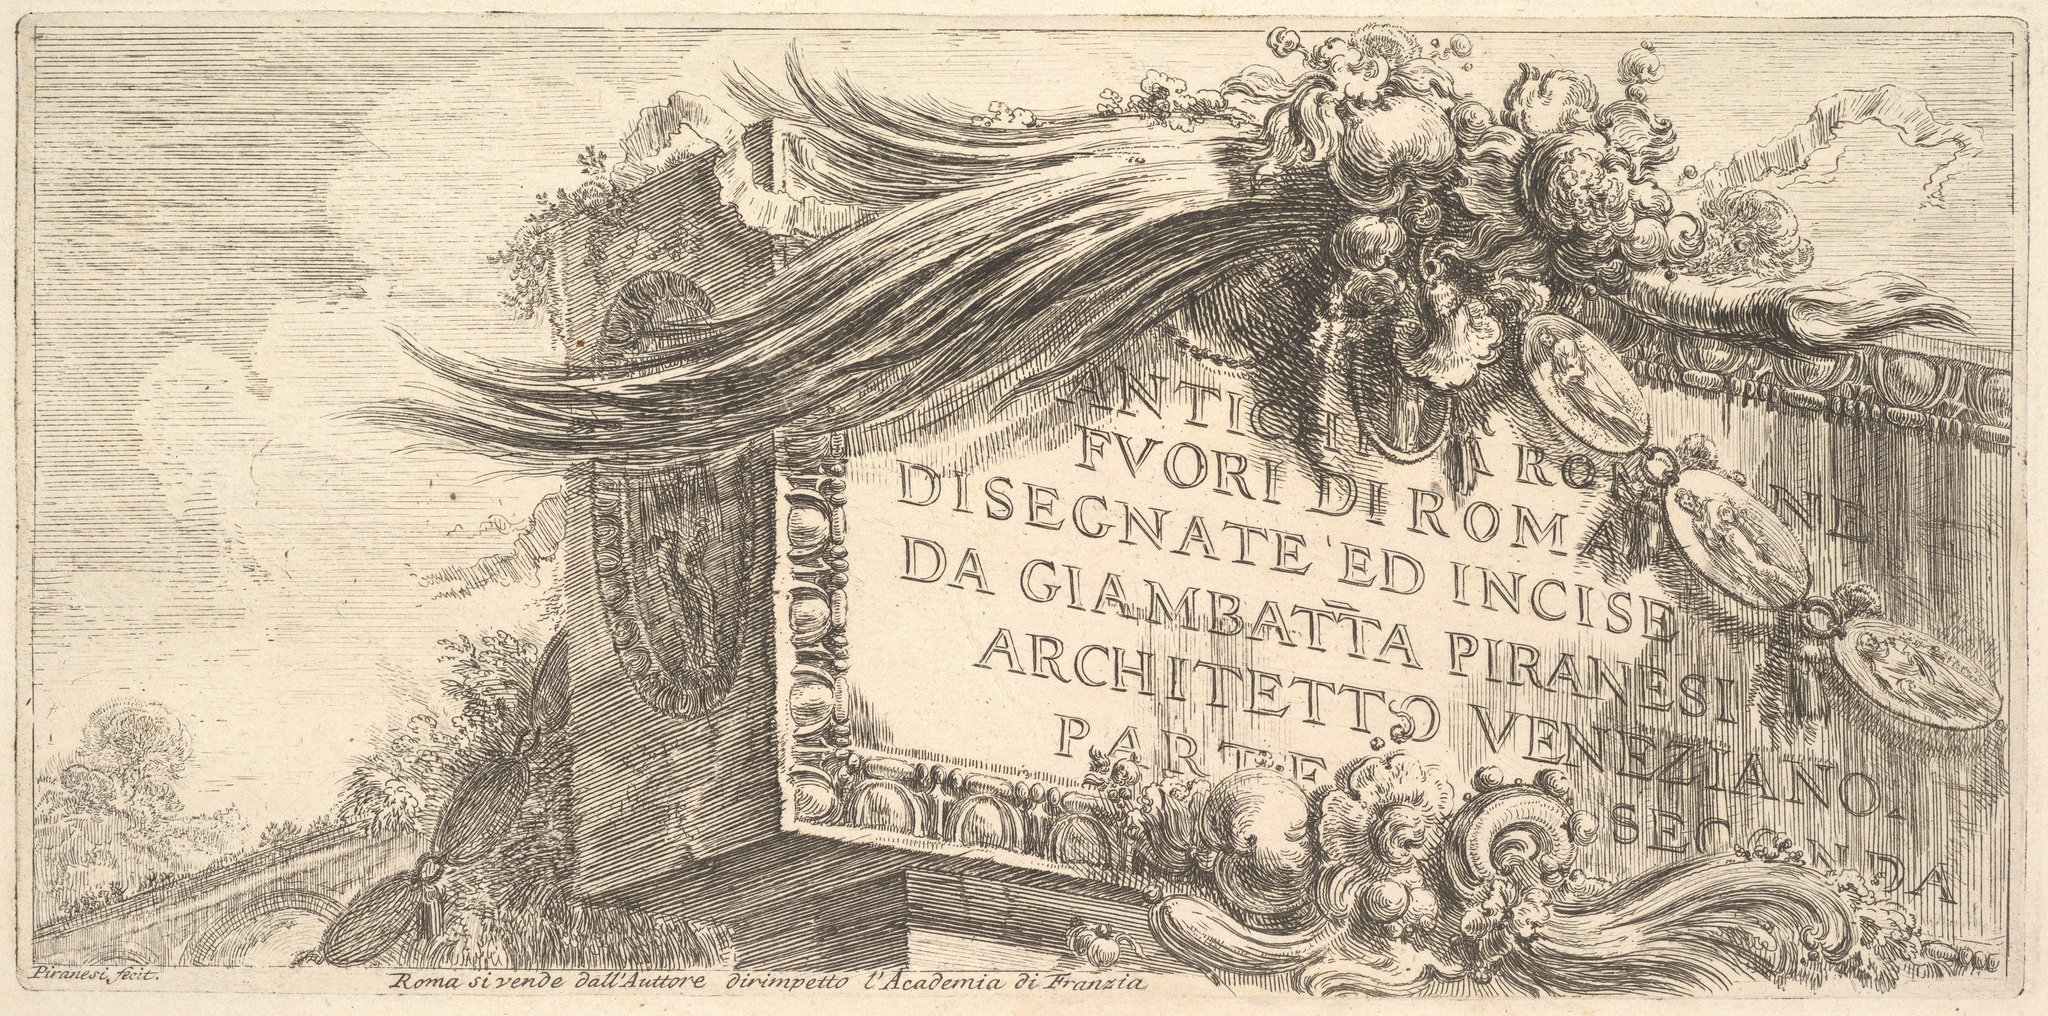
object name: print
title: Frontispiece to "Roman Antiquities outside Rome drawn and etched by Giambat'ta Piranesi, Venetian Architect Part Two" (ANTCHITÀ ROMANE FUORI DI ROMA DISEGNATE ED INCISE DA GIAMBAT'TA PIRANESI, ARCHITETTO VENEZIANO, PARTE SECONDA)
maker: giovanni battista piranesi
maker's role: artist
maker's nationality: italian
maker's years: 1720-1778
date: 1748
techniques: etching